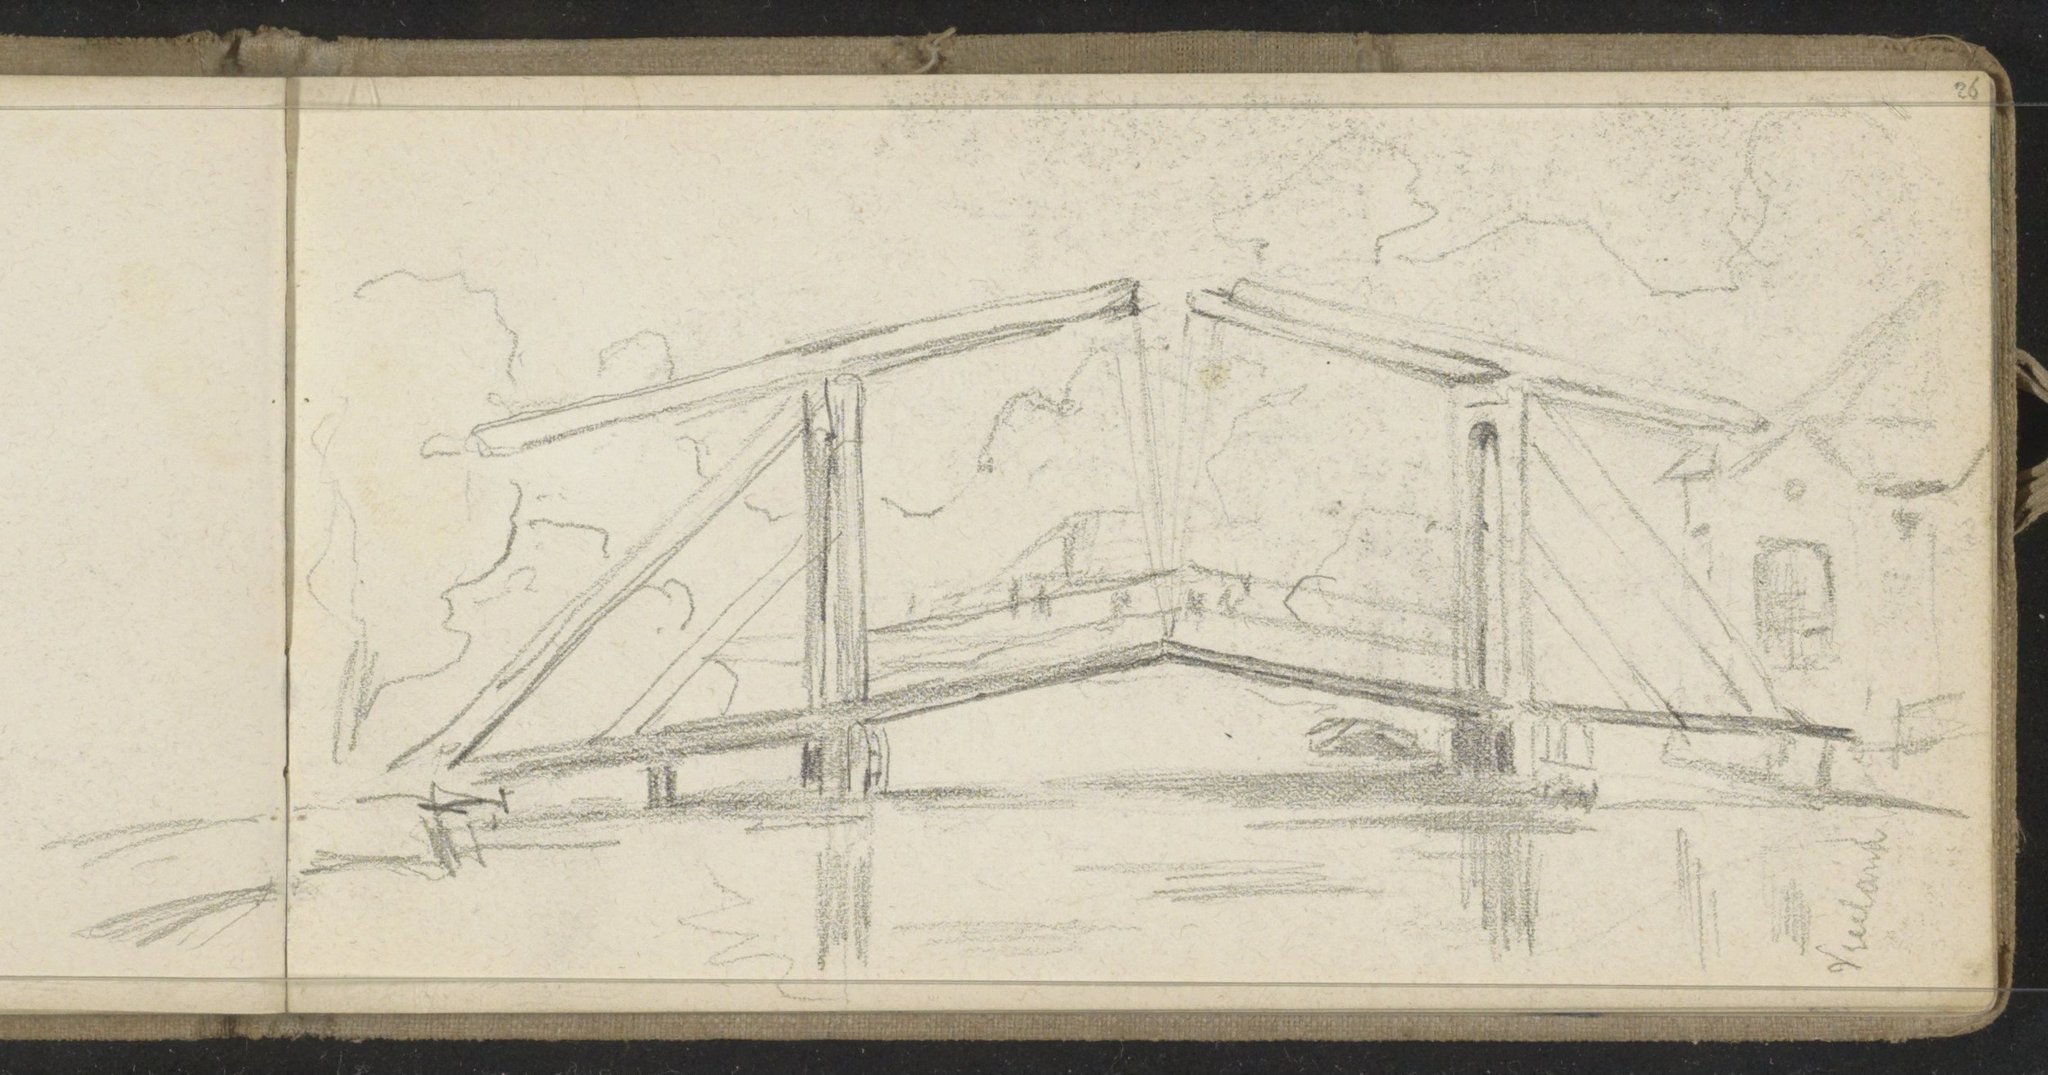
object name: sketchbook leaf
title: Ophaalbrug te Vreeland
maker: willem cornelis rip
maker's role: draughtsman, painter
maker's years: 1856-1922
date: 1895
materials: paper, pencil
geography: vreeland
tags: bridge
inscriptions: annotation: ‘Vreeland’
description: Blad 26 recto uit een schetsboek met 39 bladen.